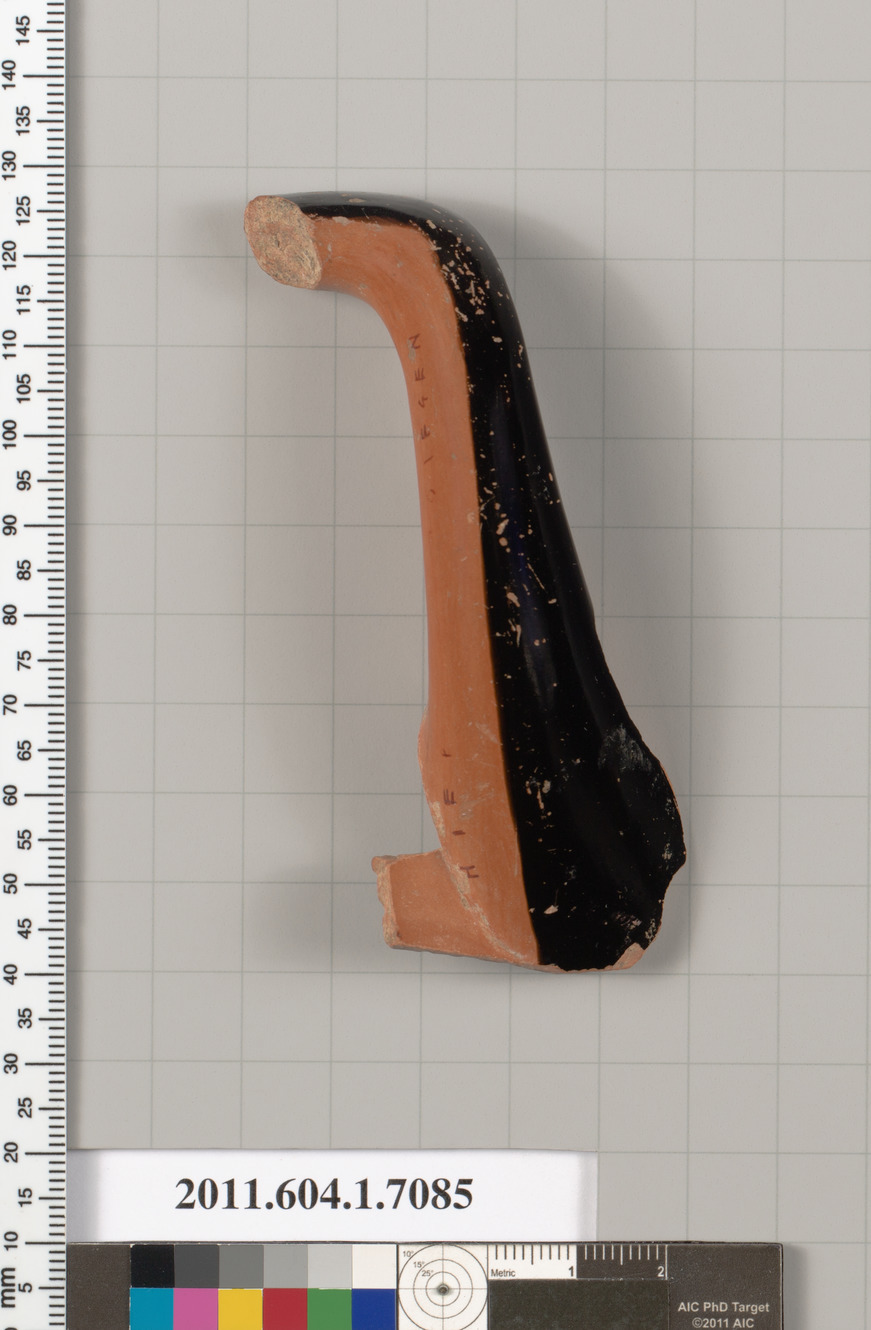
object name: kylix fragment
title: Terracotta fragment of a kylix (drinking cup)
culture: greek, attic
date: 500-480 BCE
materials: terracotta